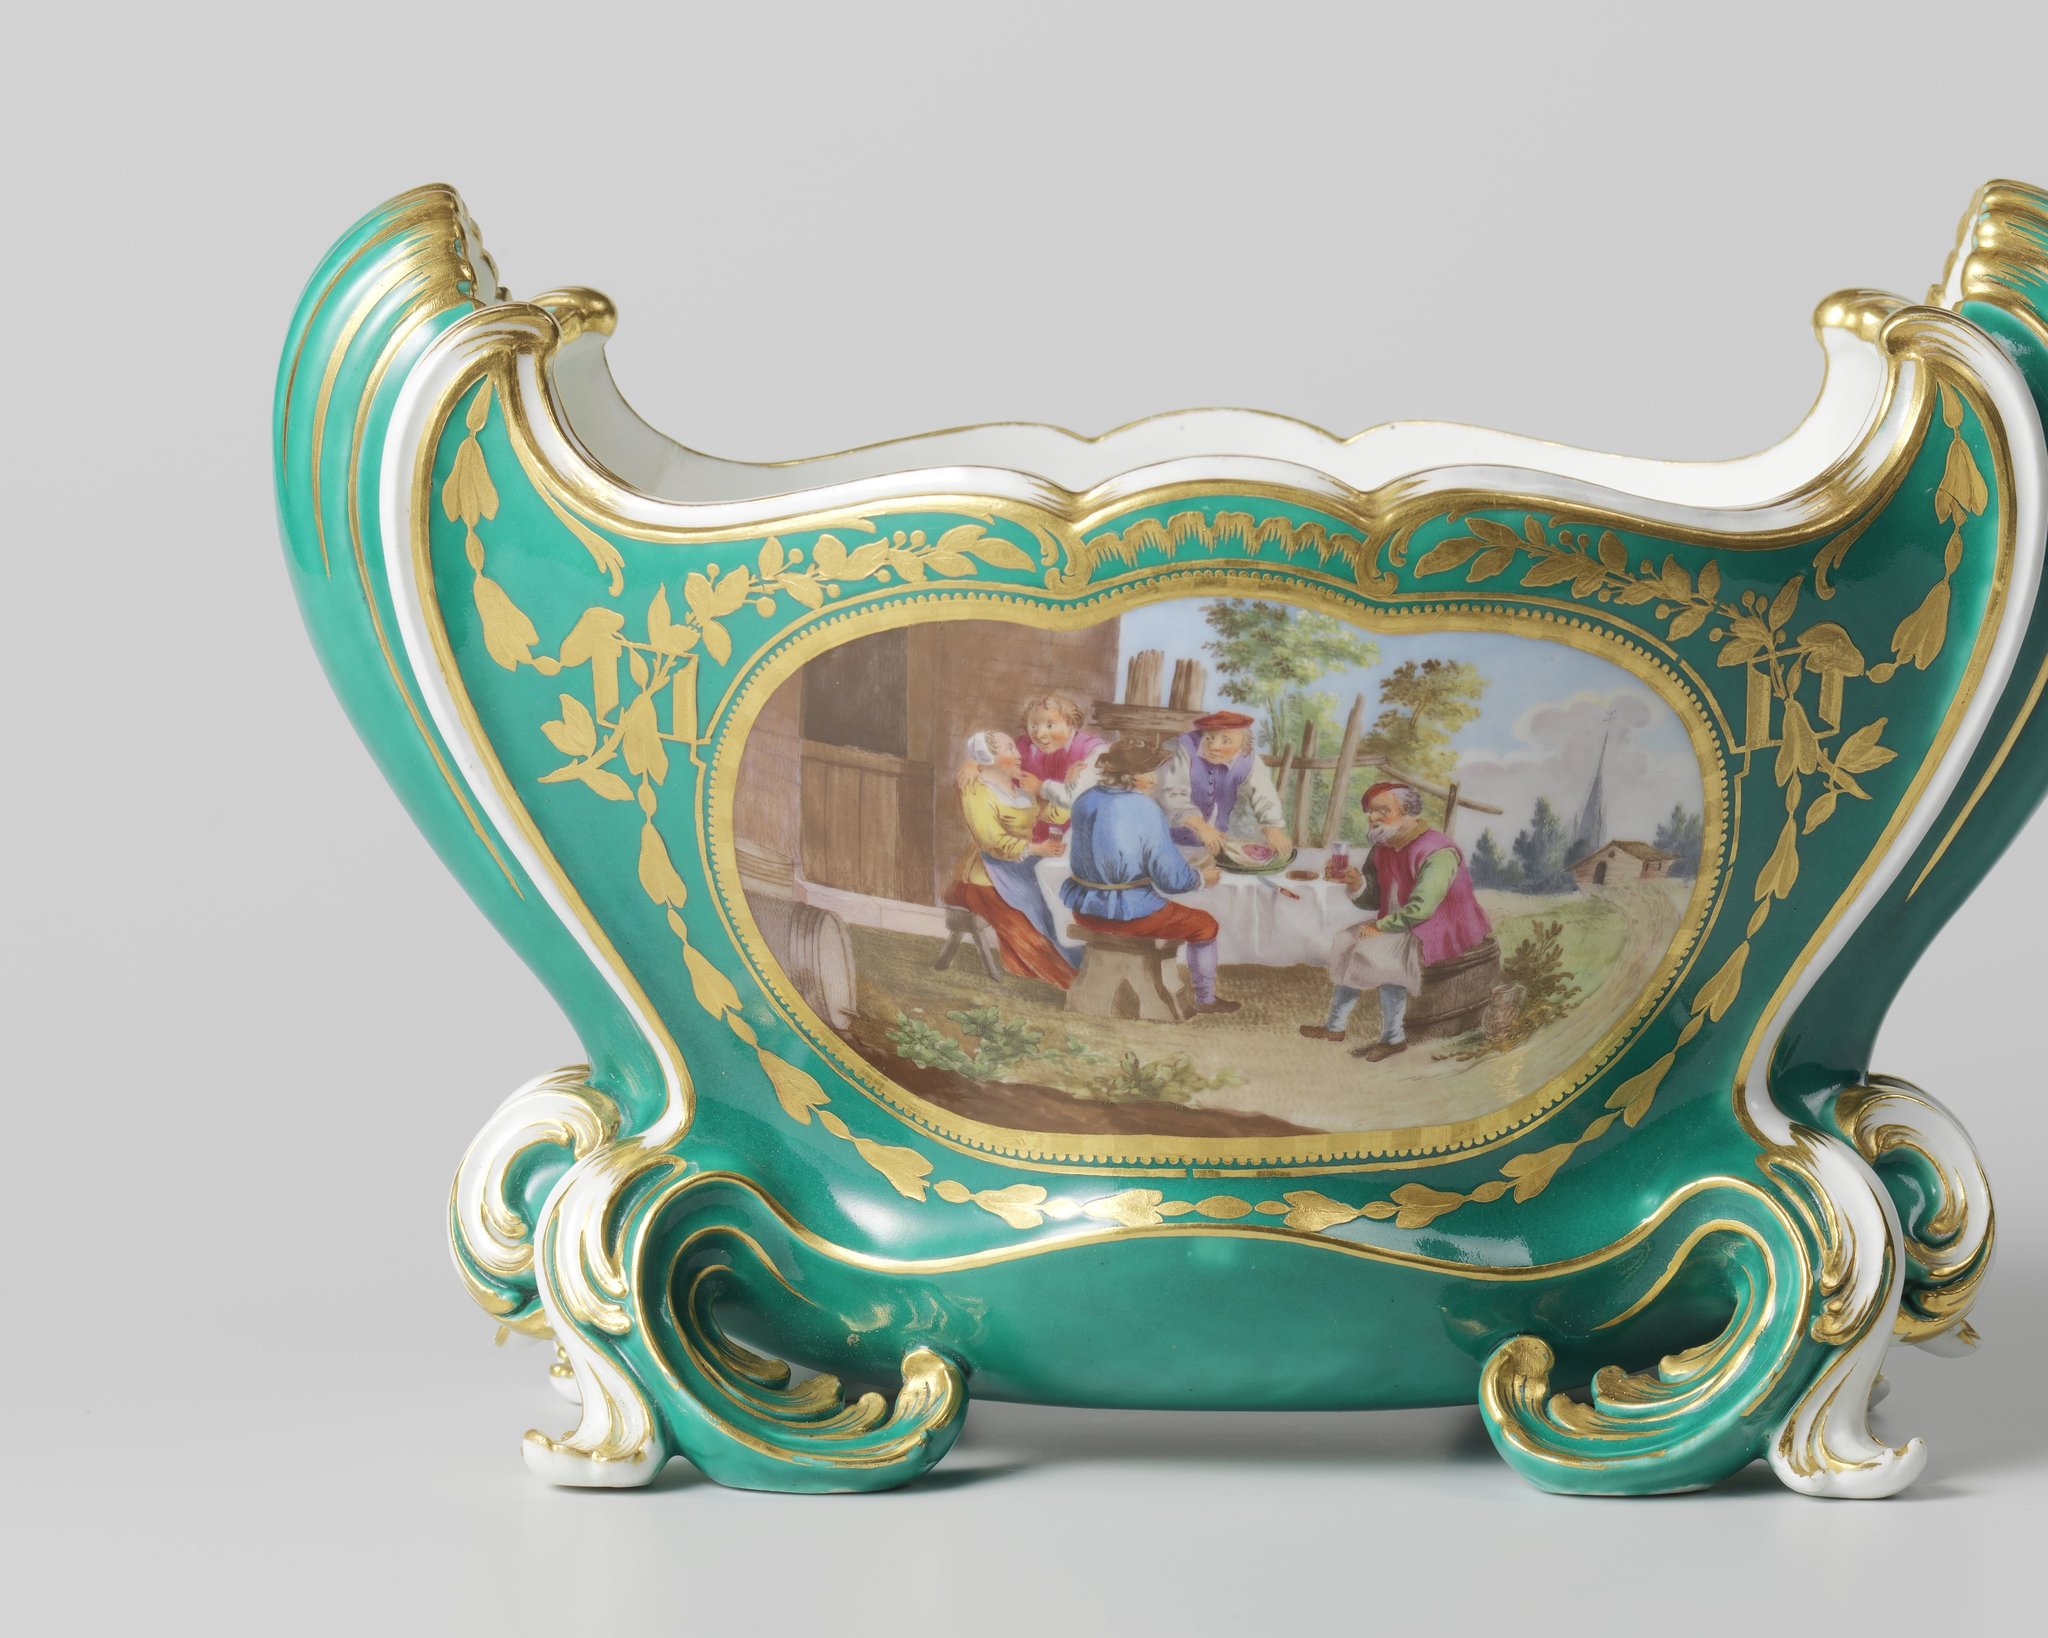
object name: jardinière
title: Flower vase (cuvette Mahon)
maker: jean-claude chambellan duplessis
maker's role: goldsmith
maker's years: 1699-1774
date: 1761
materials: porcelain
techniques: gilding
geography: sèvres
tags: (family) meal - cc - out of doors, lovers; courting, flirting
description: The form of this vase, with its boat shape, was designed to commemorate the French capture of the British-occupied Port Mahon on the island of Minorca in 1756.